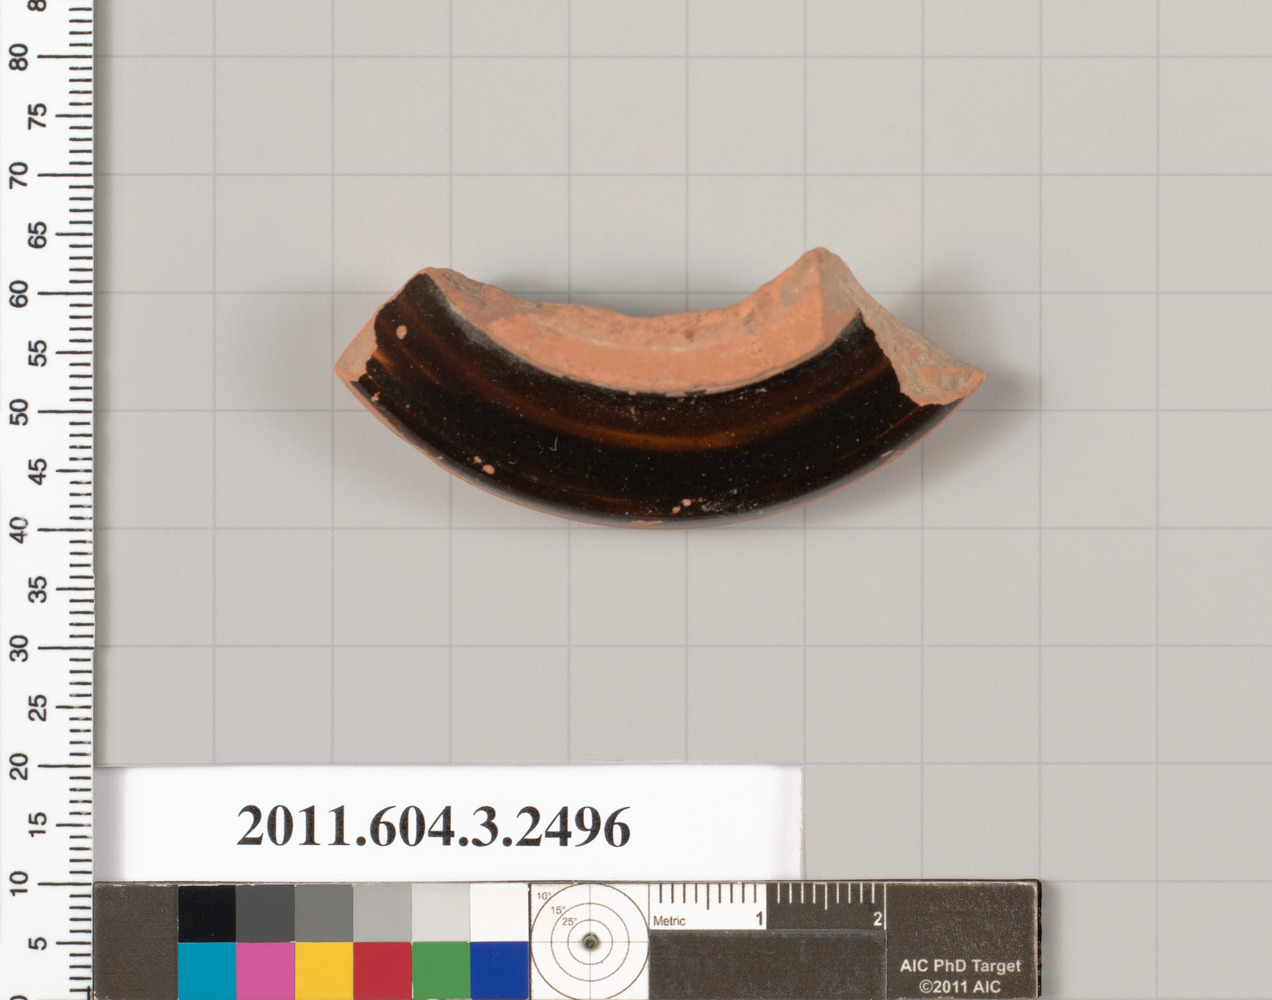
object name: kylix fragment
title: Terracotta fragment of a kylix (drinking cup)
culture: greek, attic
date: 600-401 BCE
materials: terracotta